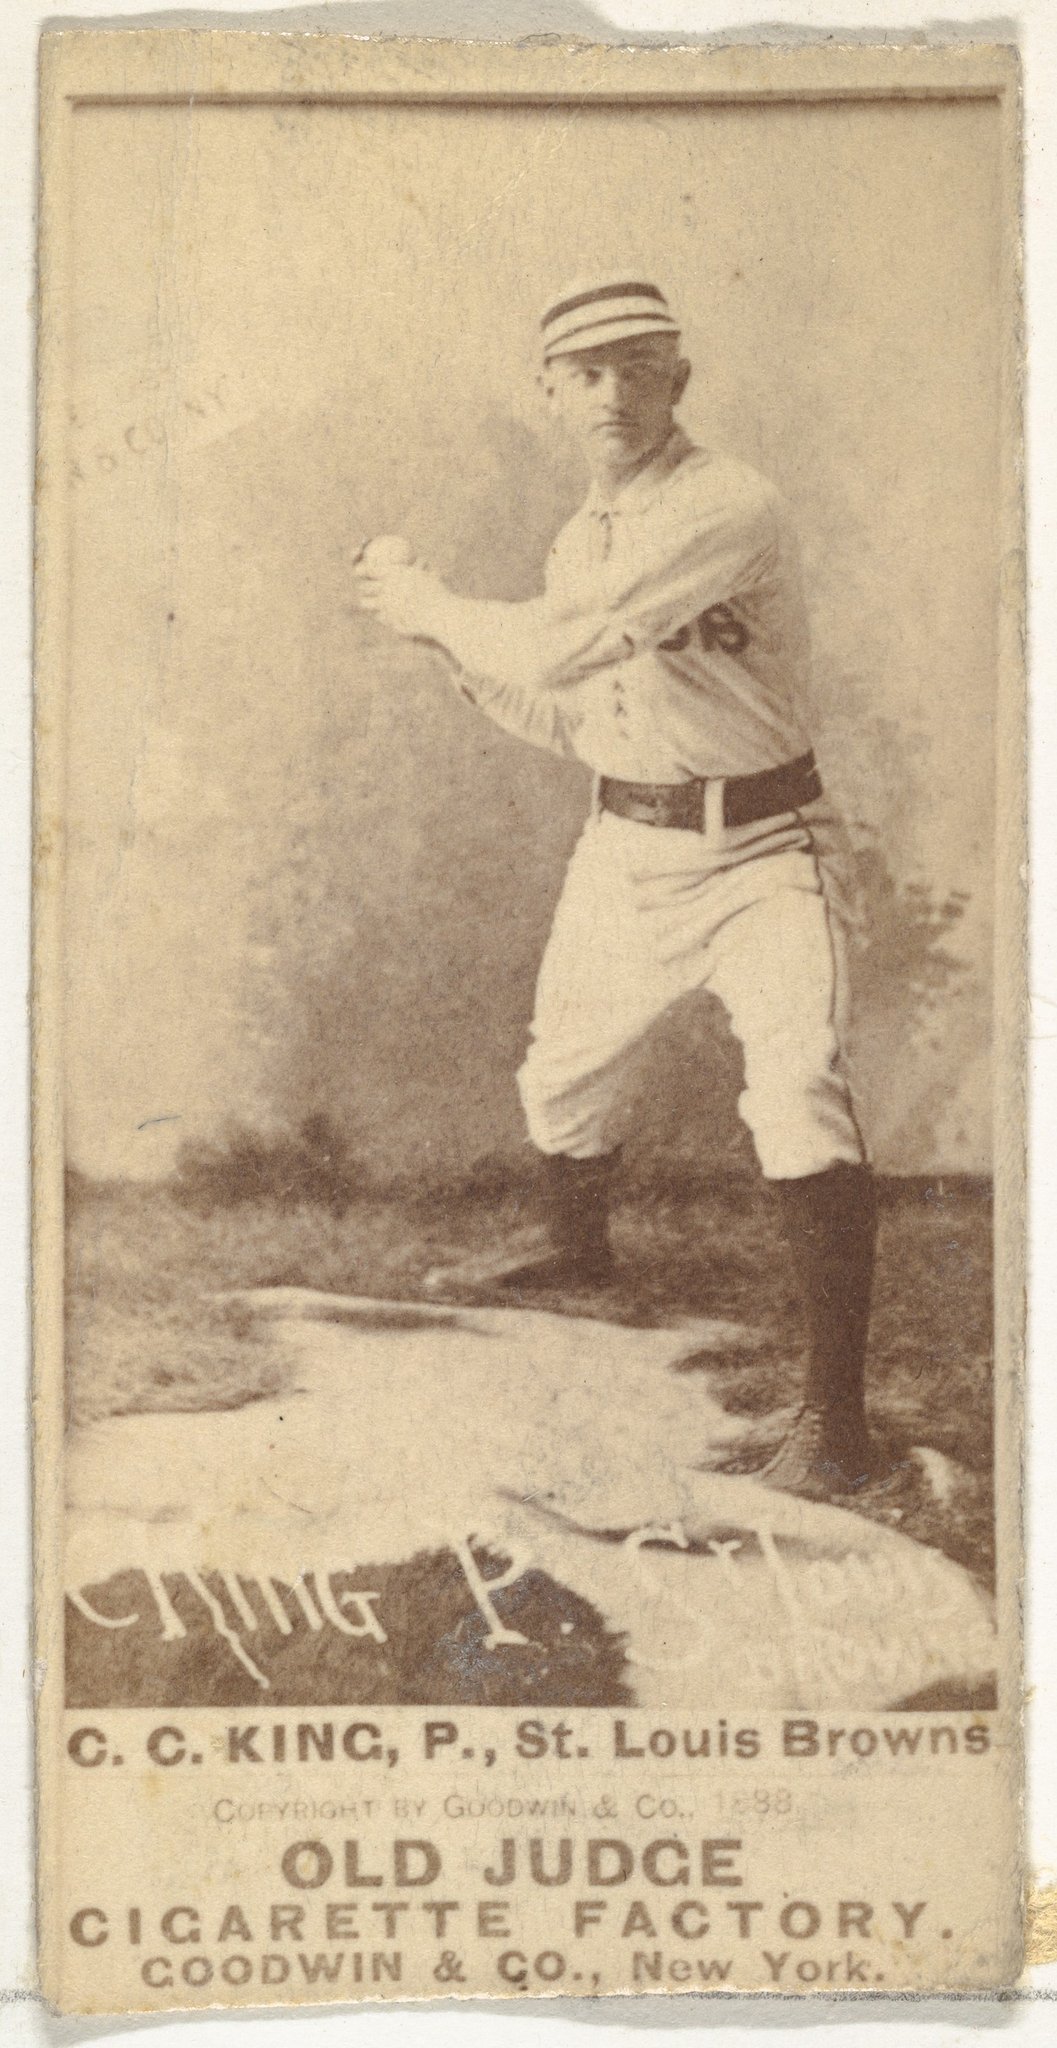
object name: baseball card, photograph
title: Charles Frederick "Silver" King, Pitcher, St. Louis Browns, from the Old Judge series (N172) for Old Judge Cigarettes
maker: goodwin & company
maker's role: publisher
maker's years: 1850-1950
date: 1888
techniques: albumen silver print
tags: men,portraits,baseball,athletes